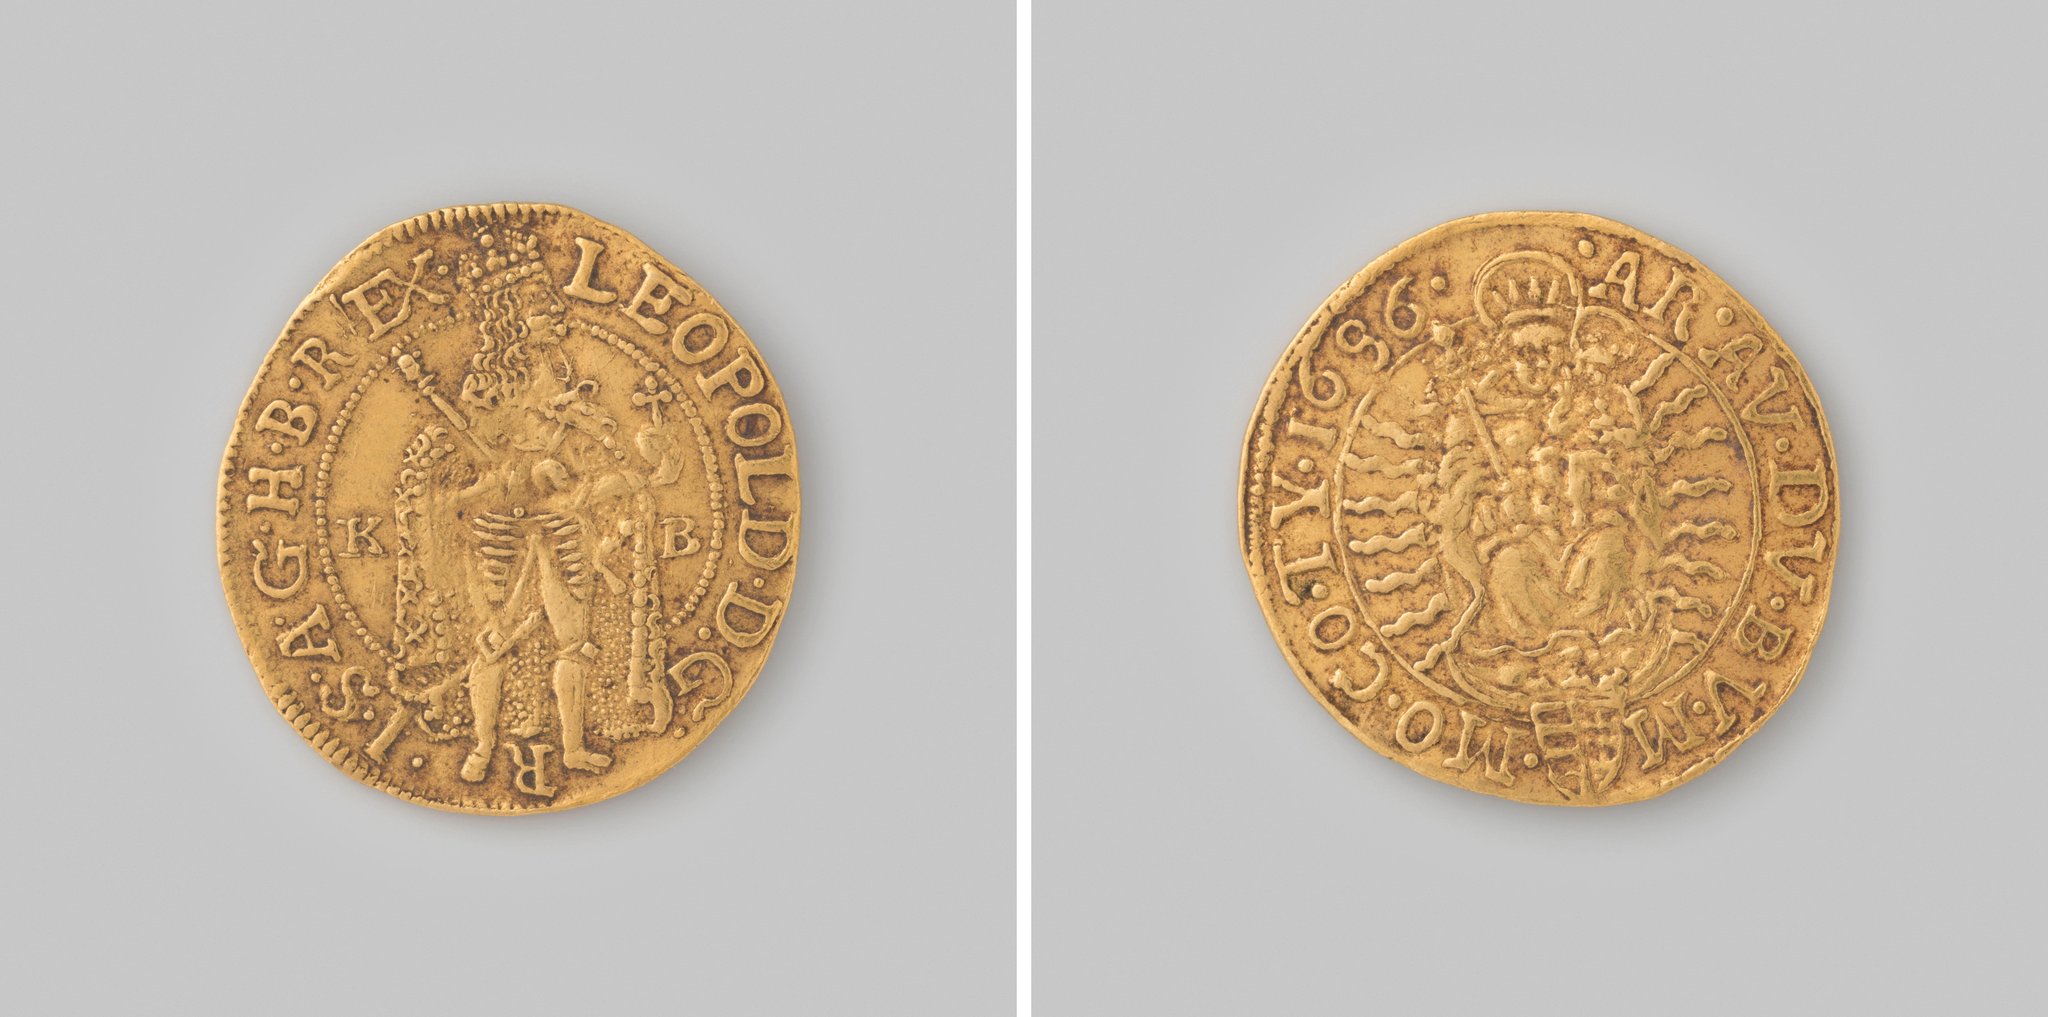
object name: ducat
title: Dukaat uit Hongarije van Leopold I,1686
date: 1686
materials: gold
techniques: striking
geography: kremnica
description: Gouden munt. Voorzijde: tussen letters K en B [=Kremnitz] de gekroonde vorst, staande, met in zijn linkerhand een rijksappel en in zijn rechterhand een scepter. Keerzijde: binnen een stralenkrans de madonna met het kind, waaronder een wapenschild. Jaartal aan het eind van het omschrift.